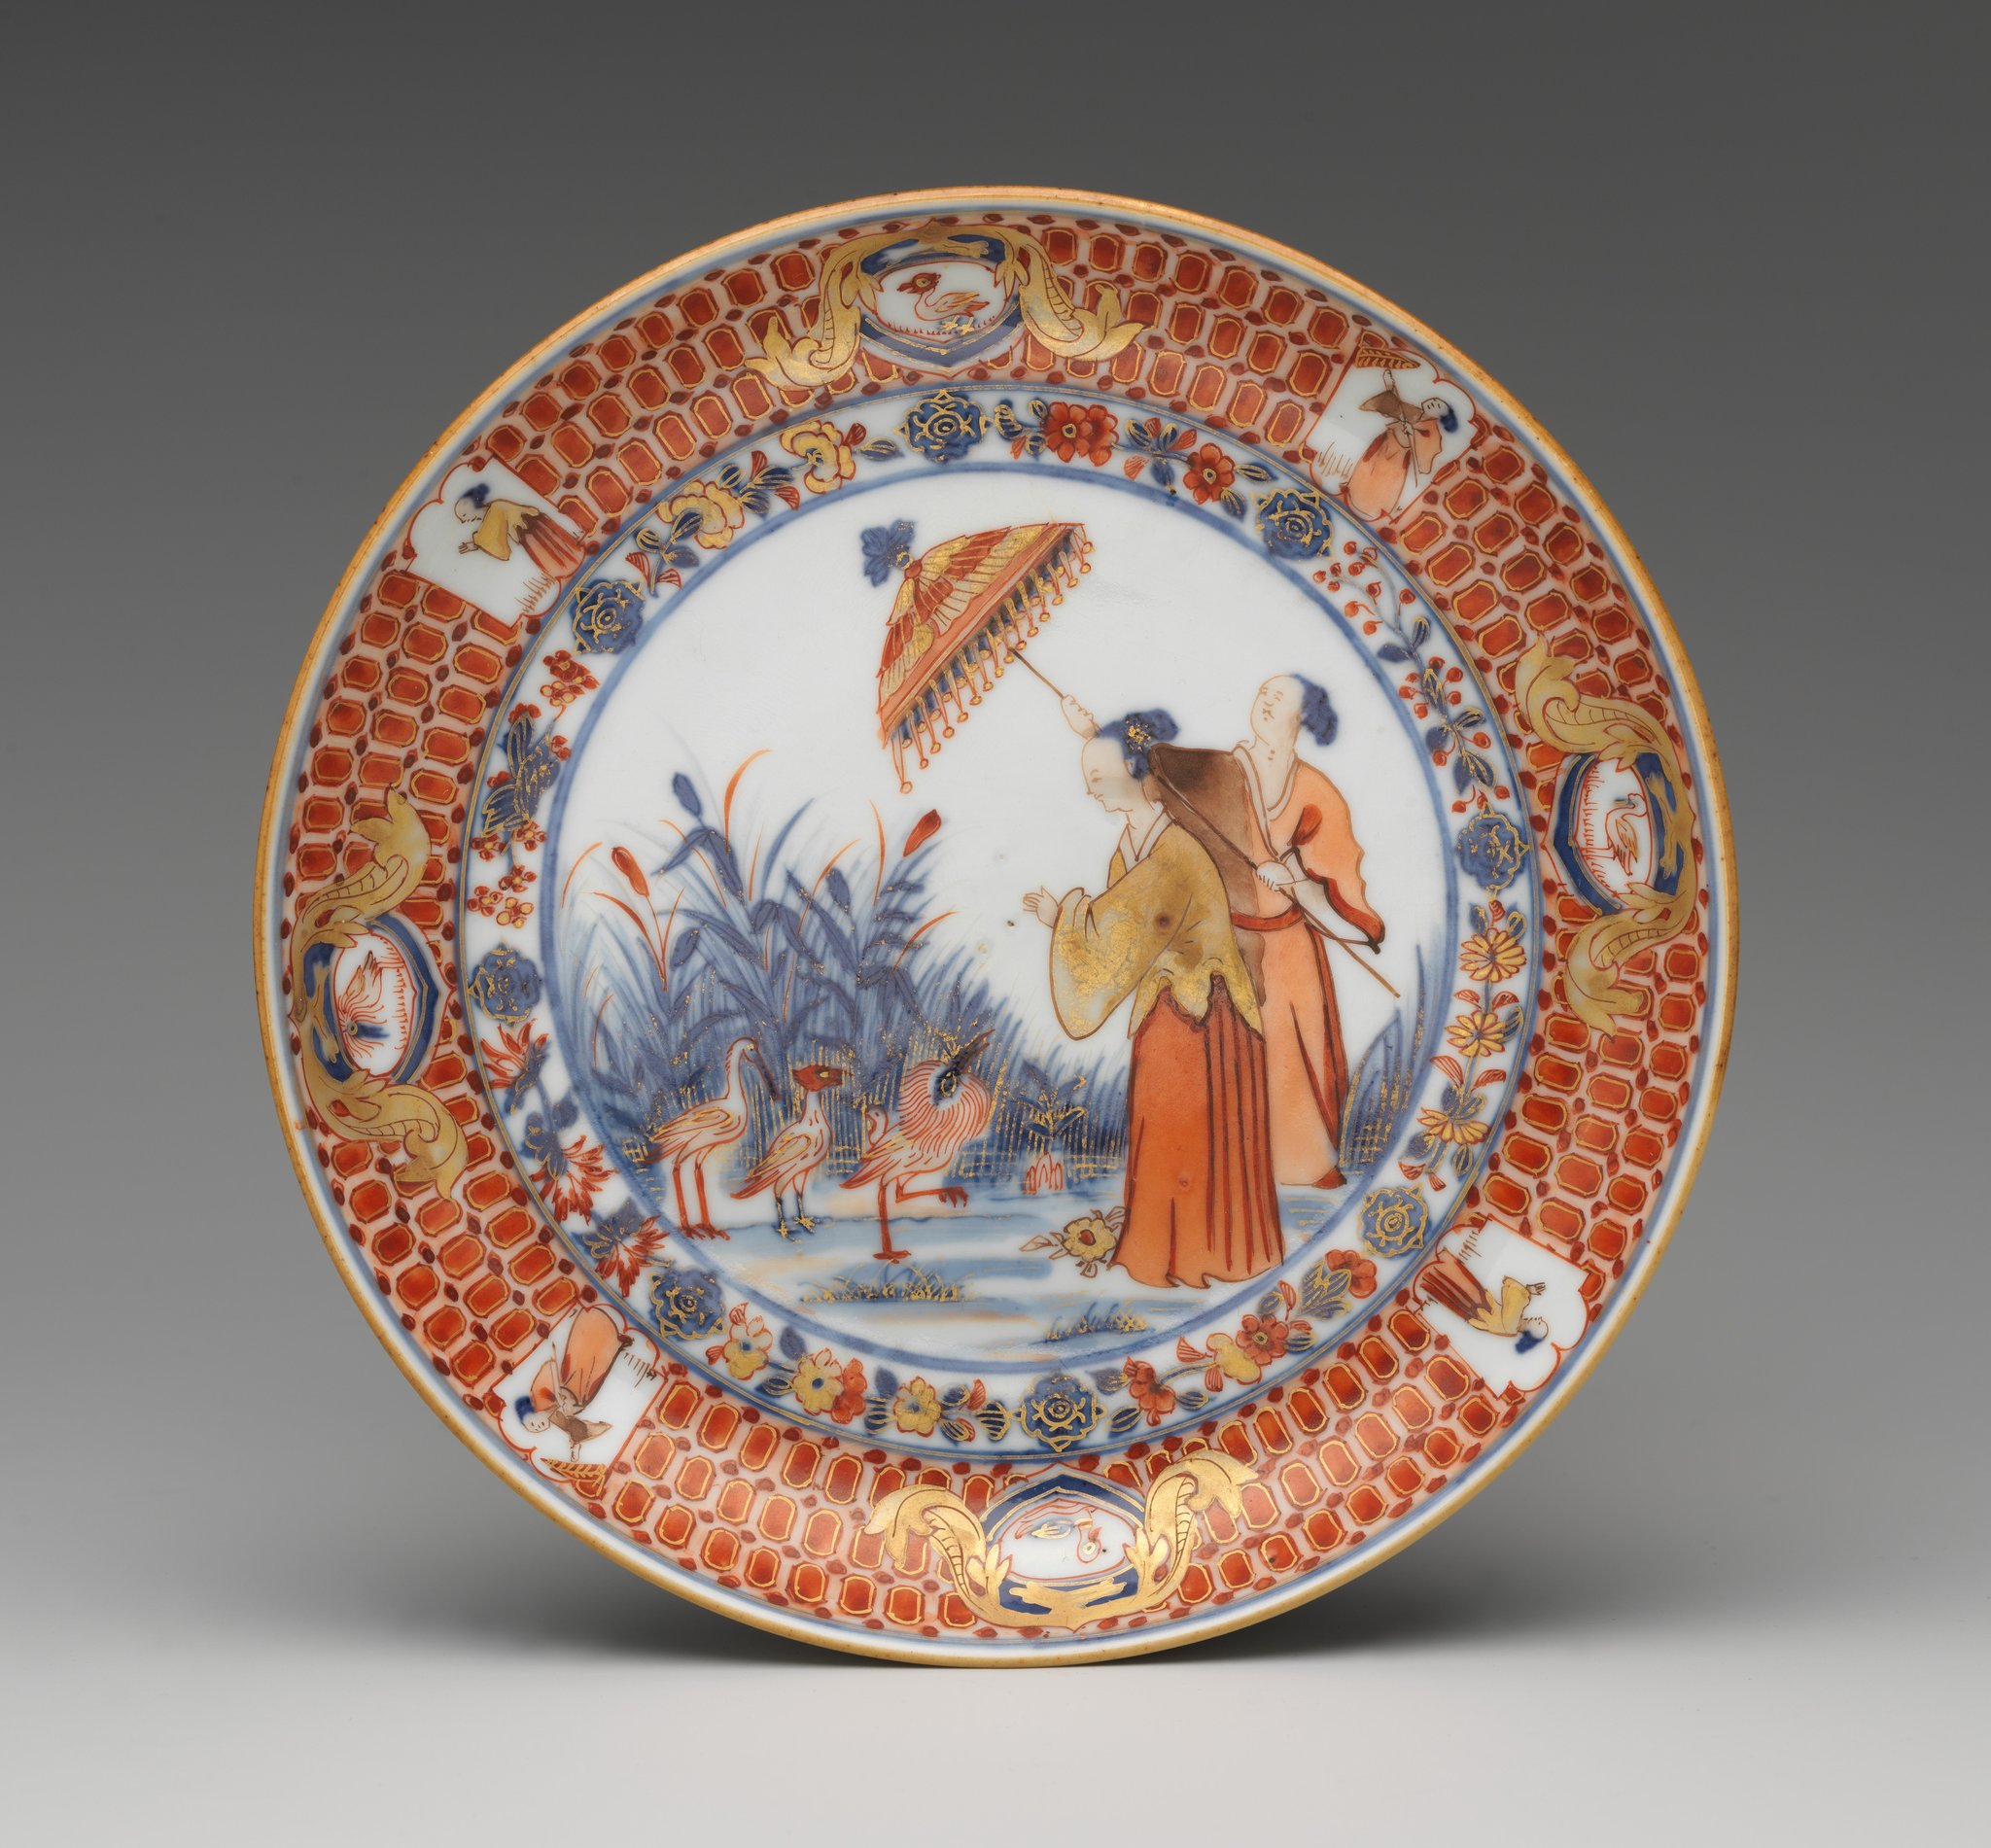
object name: dish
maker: cornelis pronk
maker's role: artist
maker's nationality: dutch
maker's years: 1691-1759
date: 1735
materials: hard paste porcelain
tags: birds,women